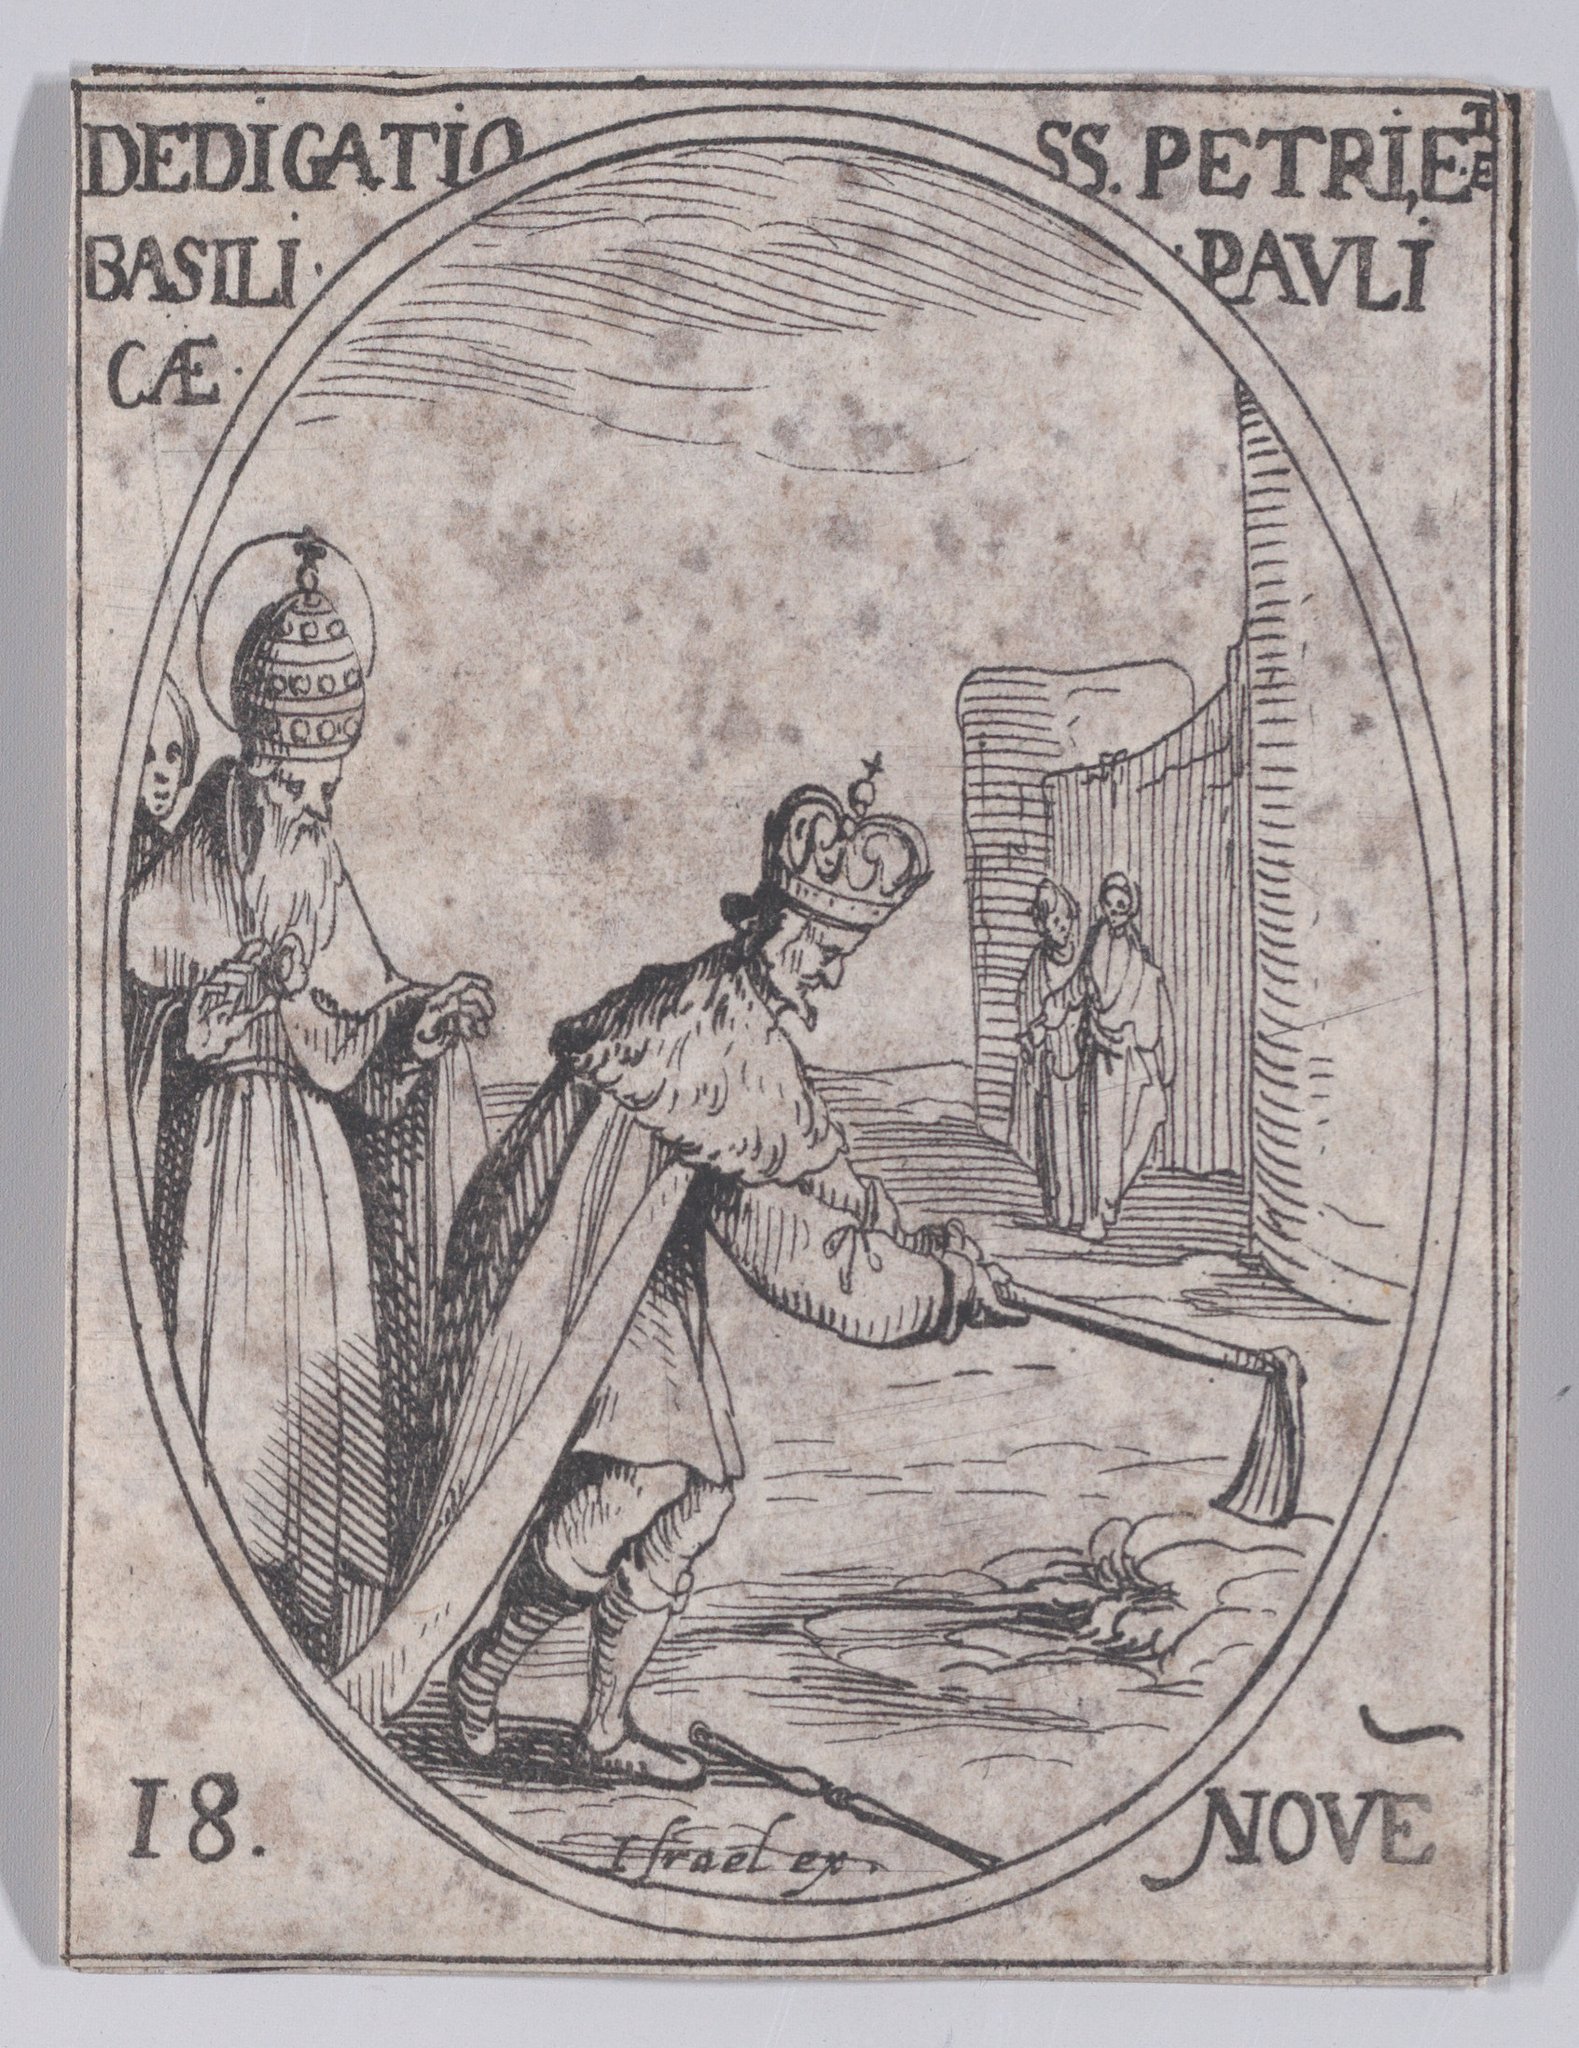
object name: print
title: Dédicace des Basiliques S. Pierre et S. Paul (Dedication of Basilicas St. Peter and St. Paul), November 18th, from "Les Images De Tous Les Saincts et Saintes de L'Année" (Images of All of the Saints and Religious Events of the Year)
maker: jacques callot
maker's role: artist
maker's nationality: french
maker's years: 1592-1635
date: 1636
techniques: etching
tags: men,saint paul,saint peter